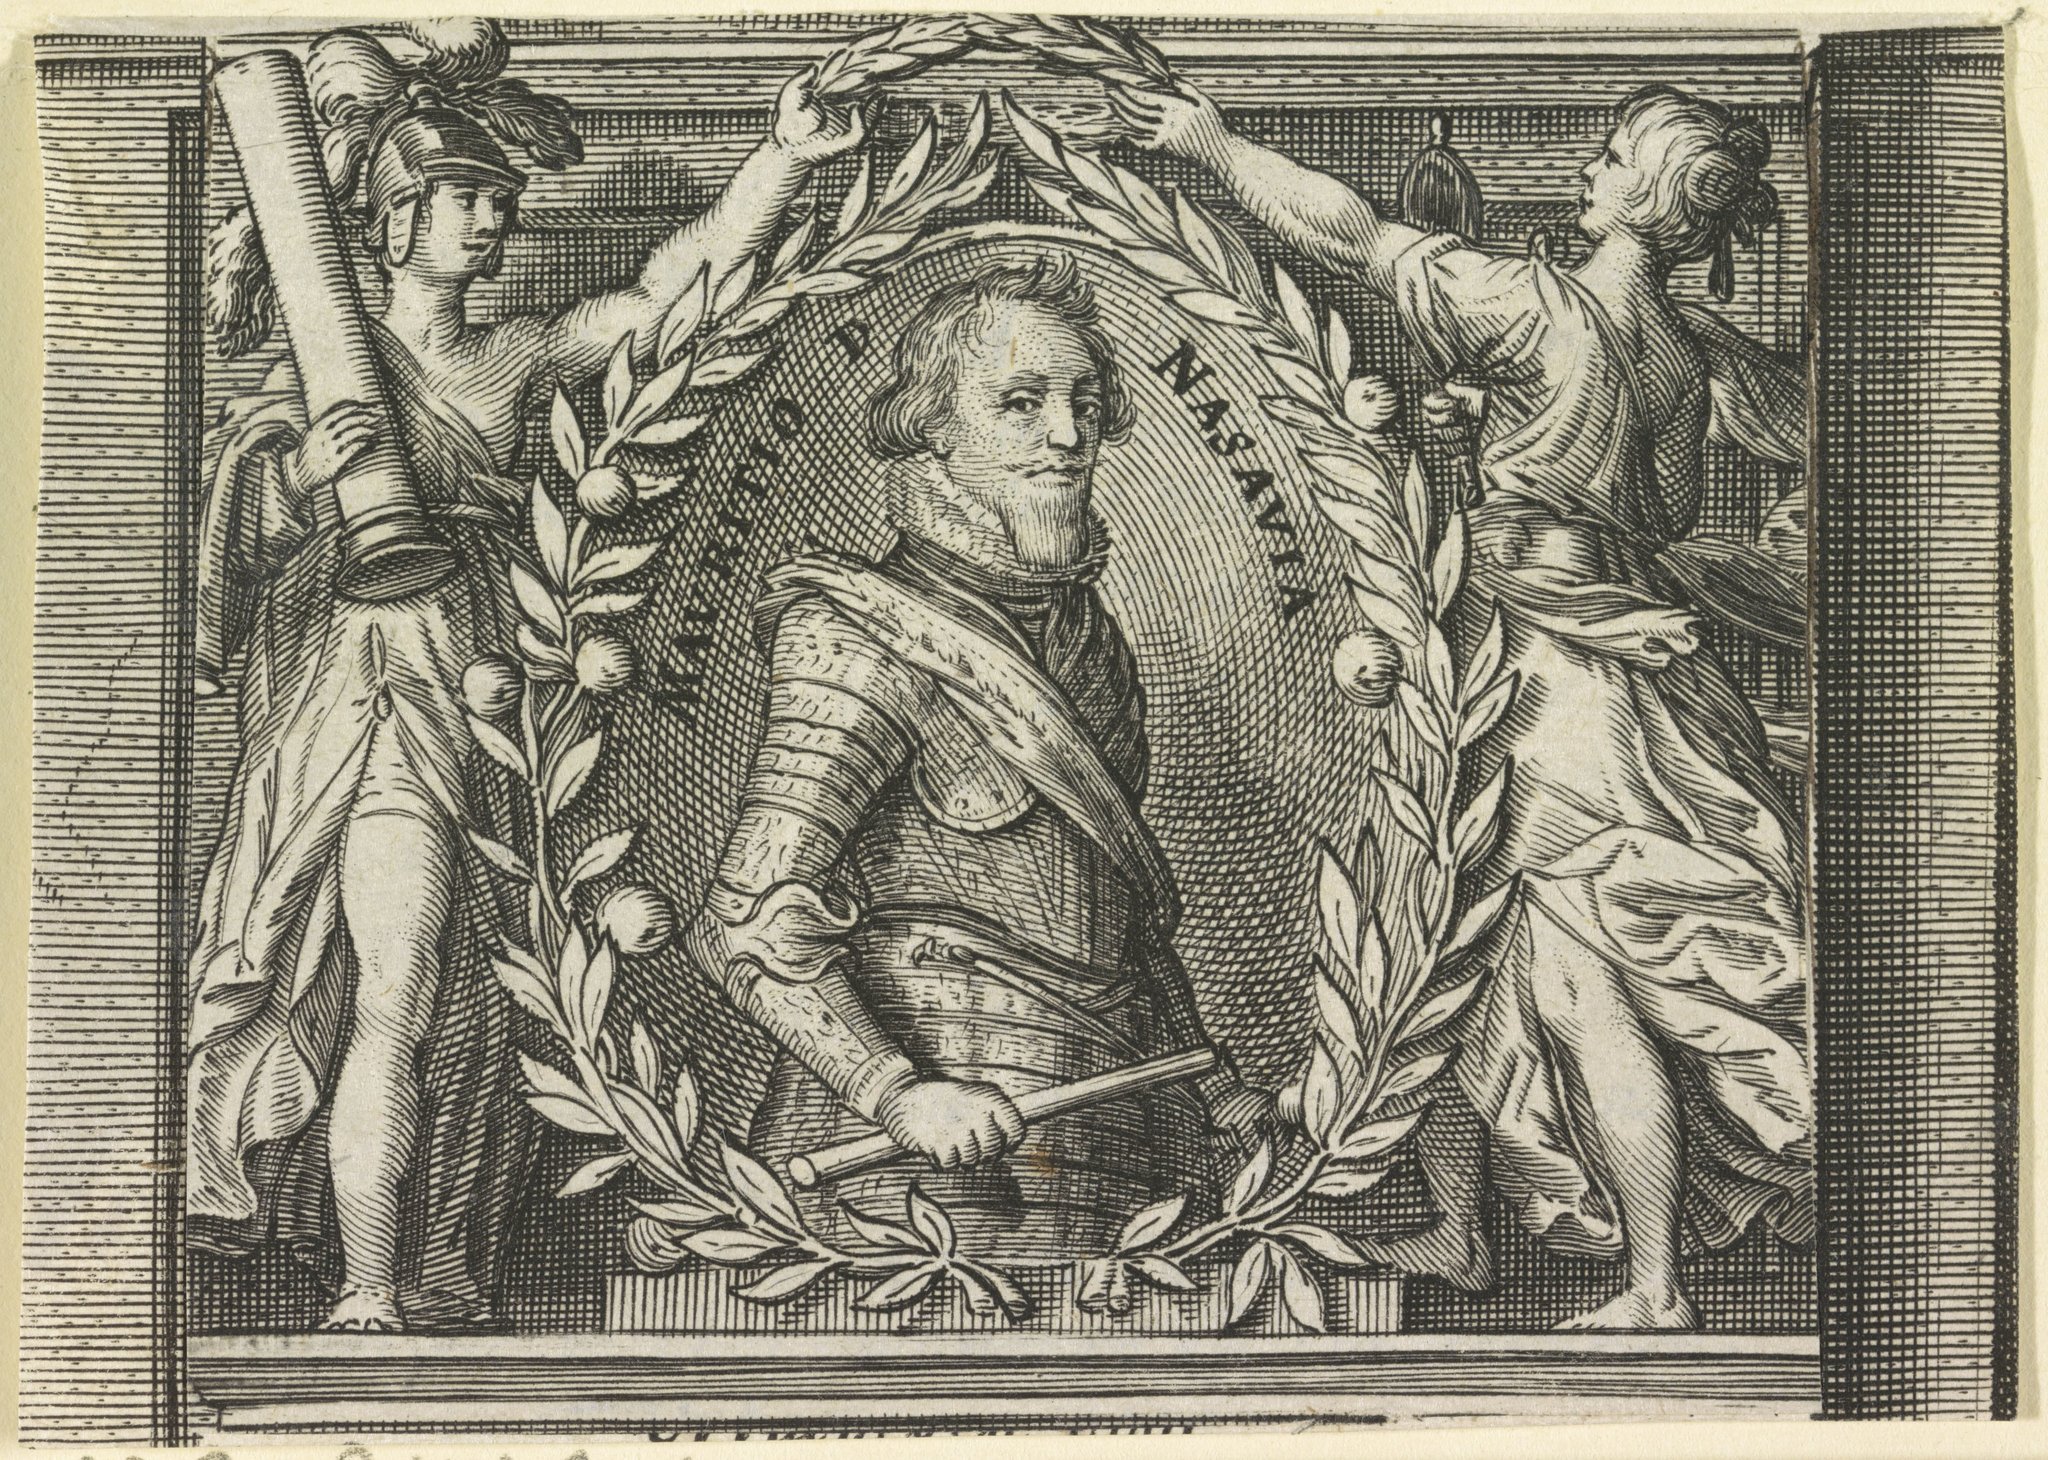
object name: print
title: Portret van Maurits, prins van Oranje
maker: Anonymous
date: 1600-1699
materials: paper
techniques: engraving, etching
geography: low countries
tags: the hague, maurice (prince of orange)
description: De hier vermelde titel verwijst naar de hoogst verkregen titel van de geportretteerde, niet per se naar de titel die de geportretteerde op deze voorstelling draagt.